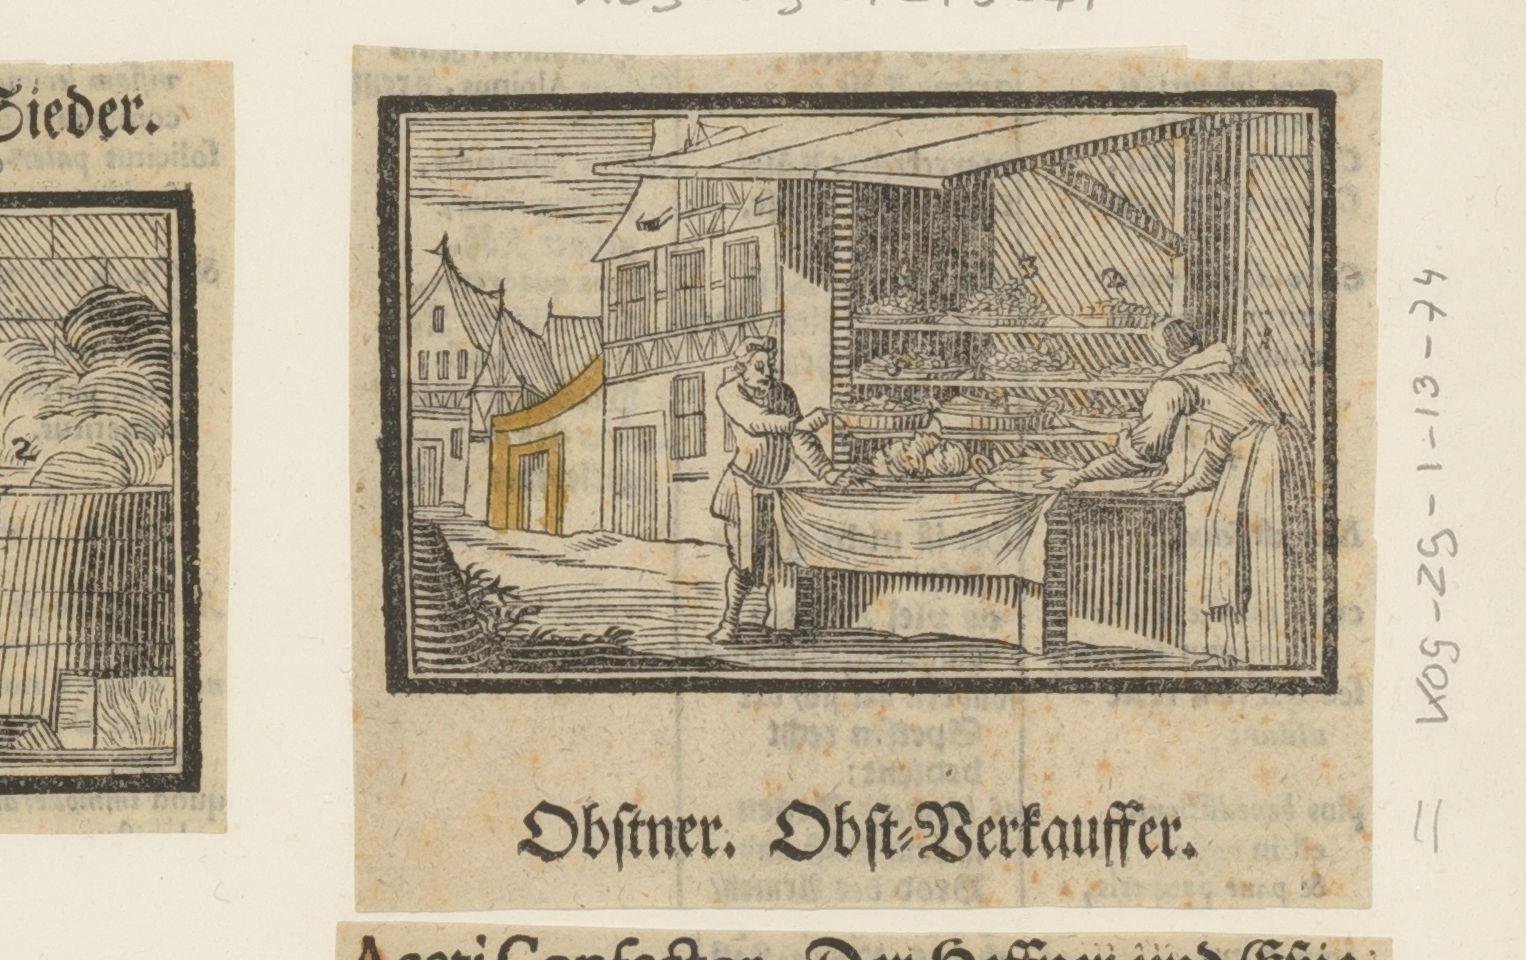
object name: book illustration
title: Fruitverkoper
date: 1730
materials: paper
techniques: letterpress printing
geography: nuremberg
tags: handicrafts ~ production of food, drink, stimulants, etc., stall, booth (~ market), fruits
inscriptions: stamp, collector's mark: Lugt 1641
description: Prent uit: Comenius, Johannes Amosius. Orbis Sensualium Picti denuo aucti Pars Secunda (...). Neurenberg: Martin Endter, 1730, dl. 2, p. 344. Prent eerder gebruikt in: Comenius, Johannes Amosius. Orbis sensualium picti pars prima (...). Neurenberg: Martin Endter, 1719, dl. 2.